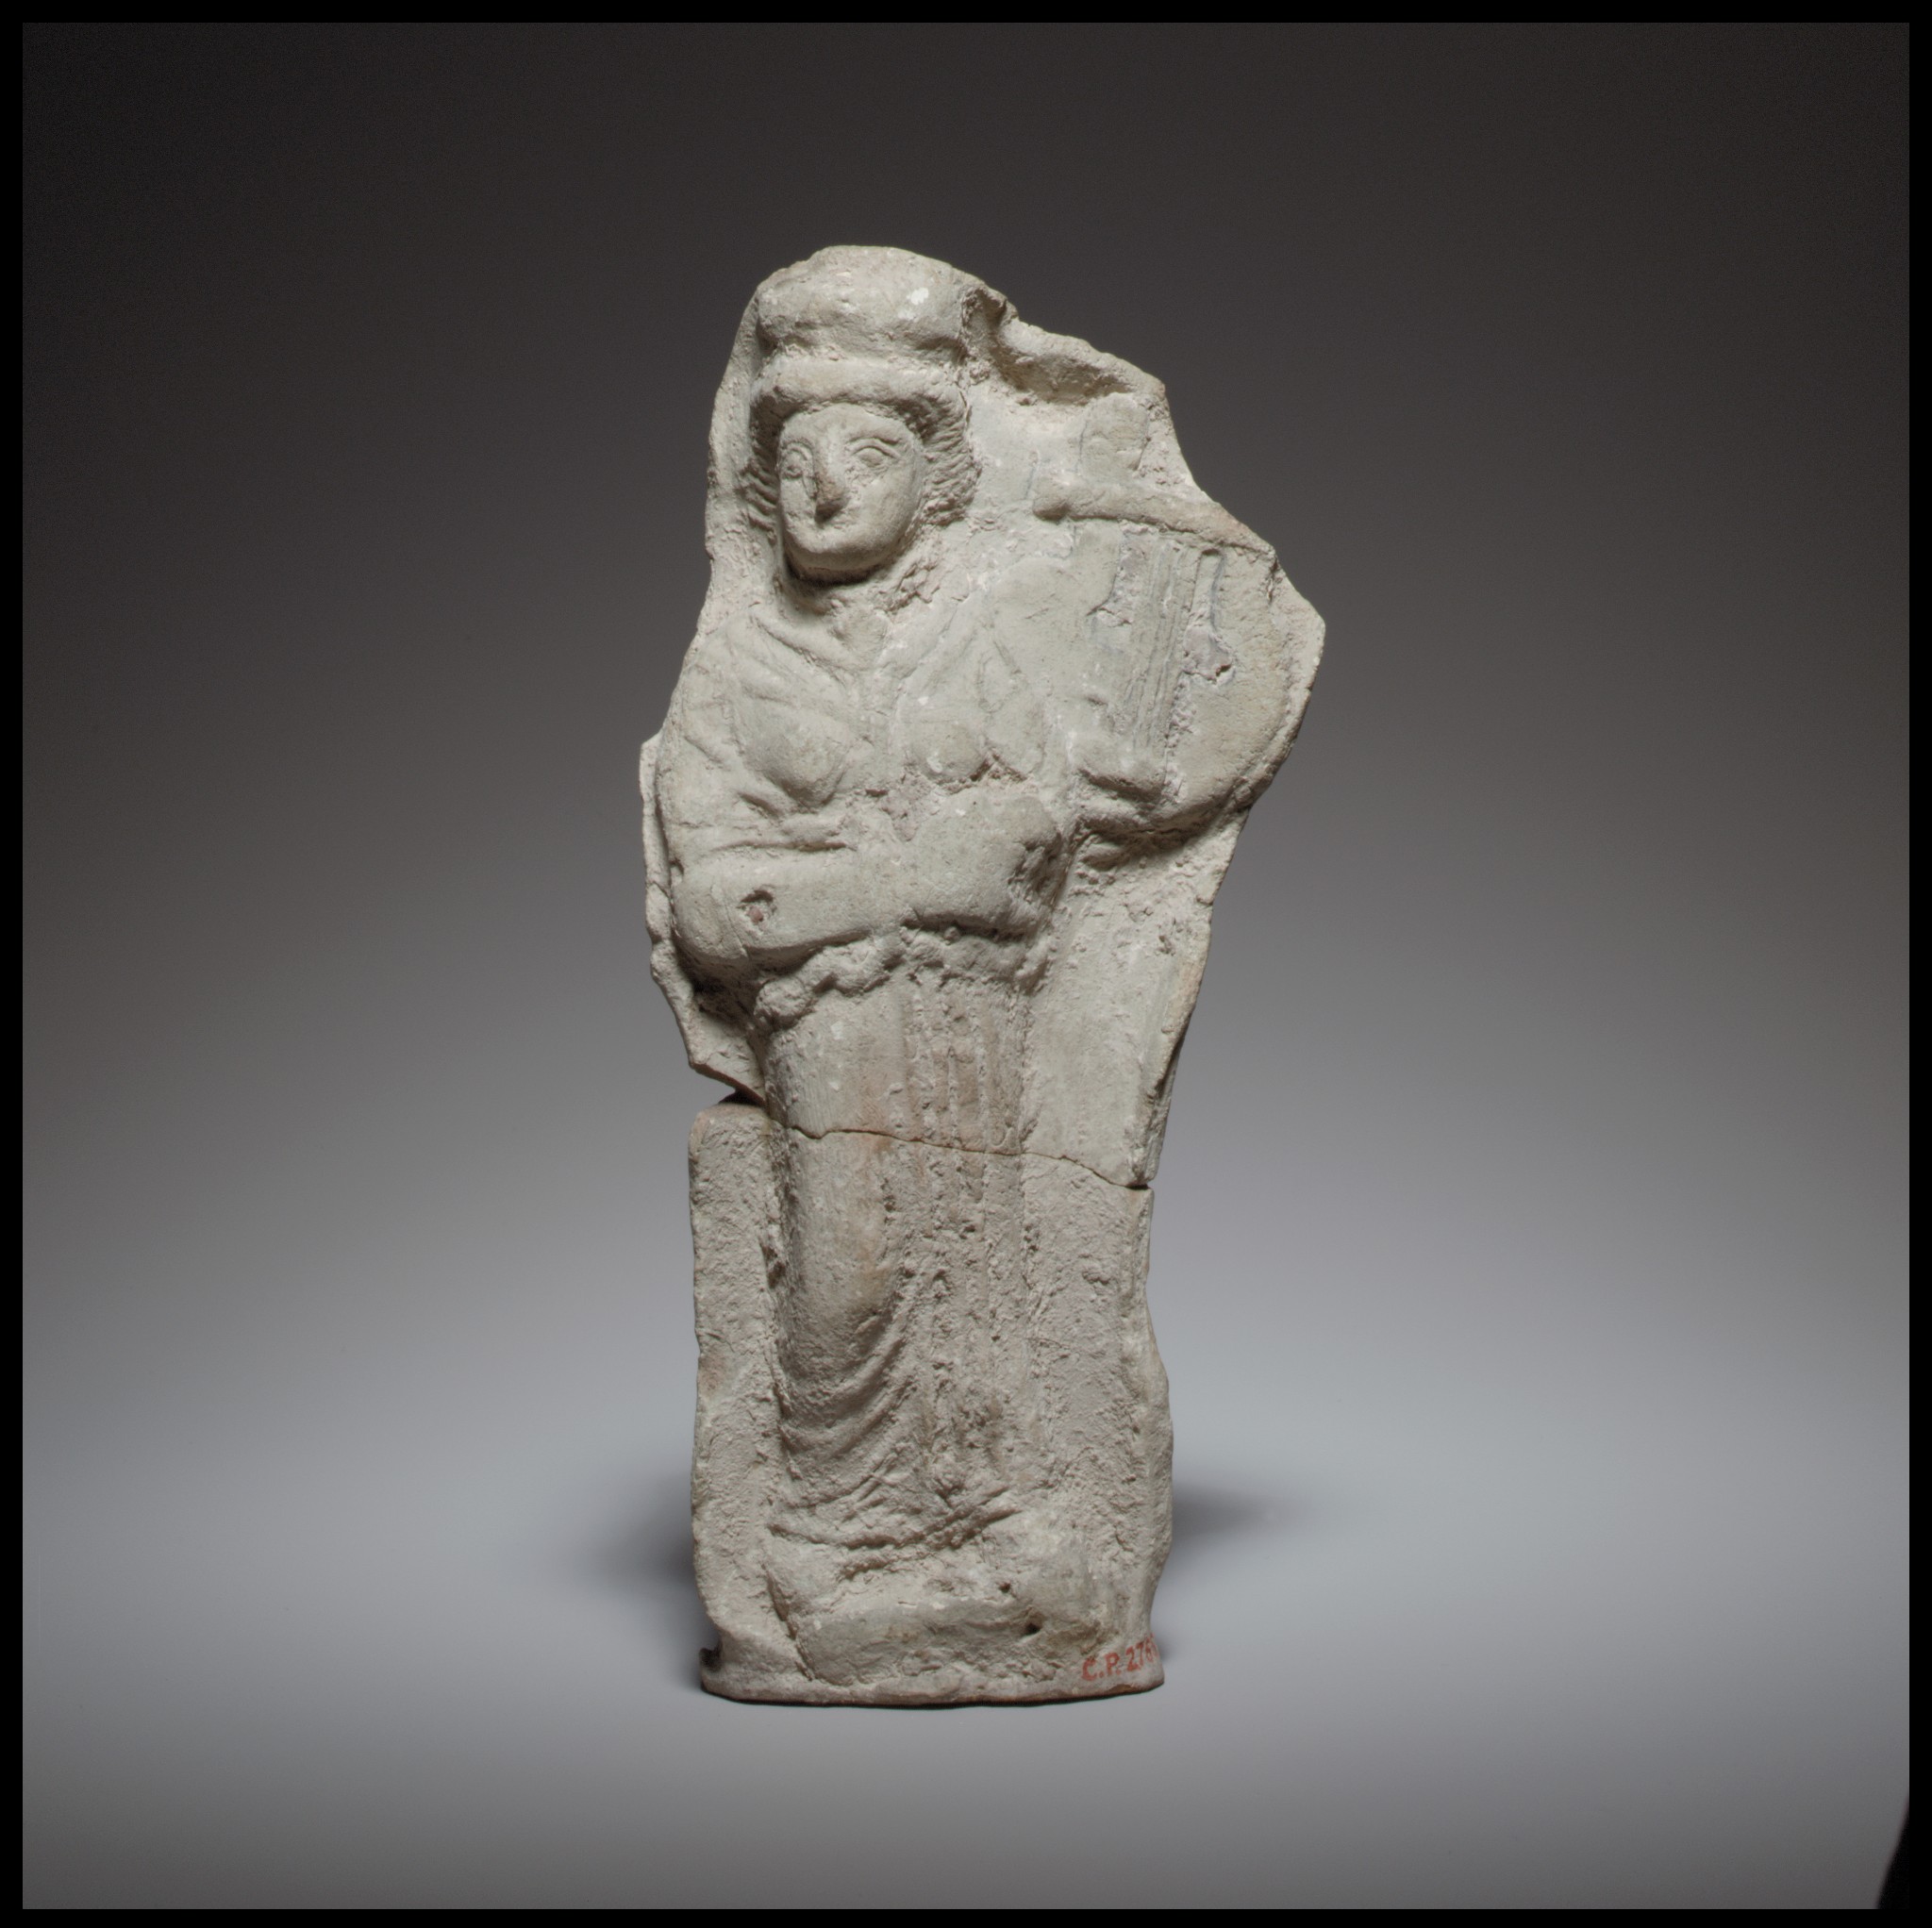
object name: statuette of a female with lyre from a ring dance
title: Standing female kithara player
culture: cypriot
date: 400-301 BCE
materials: terracotta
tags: musical instruments,women,musicians